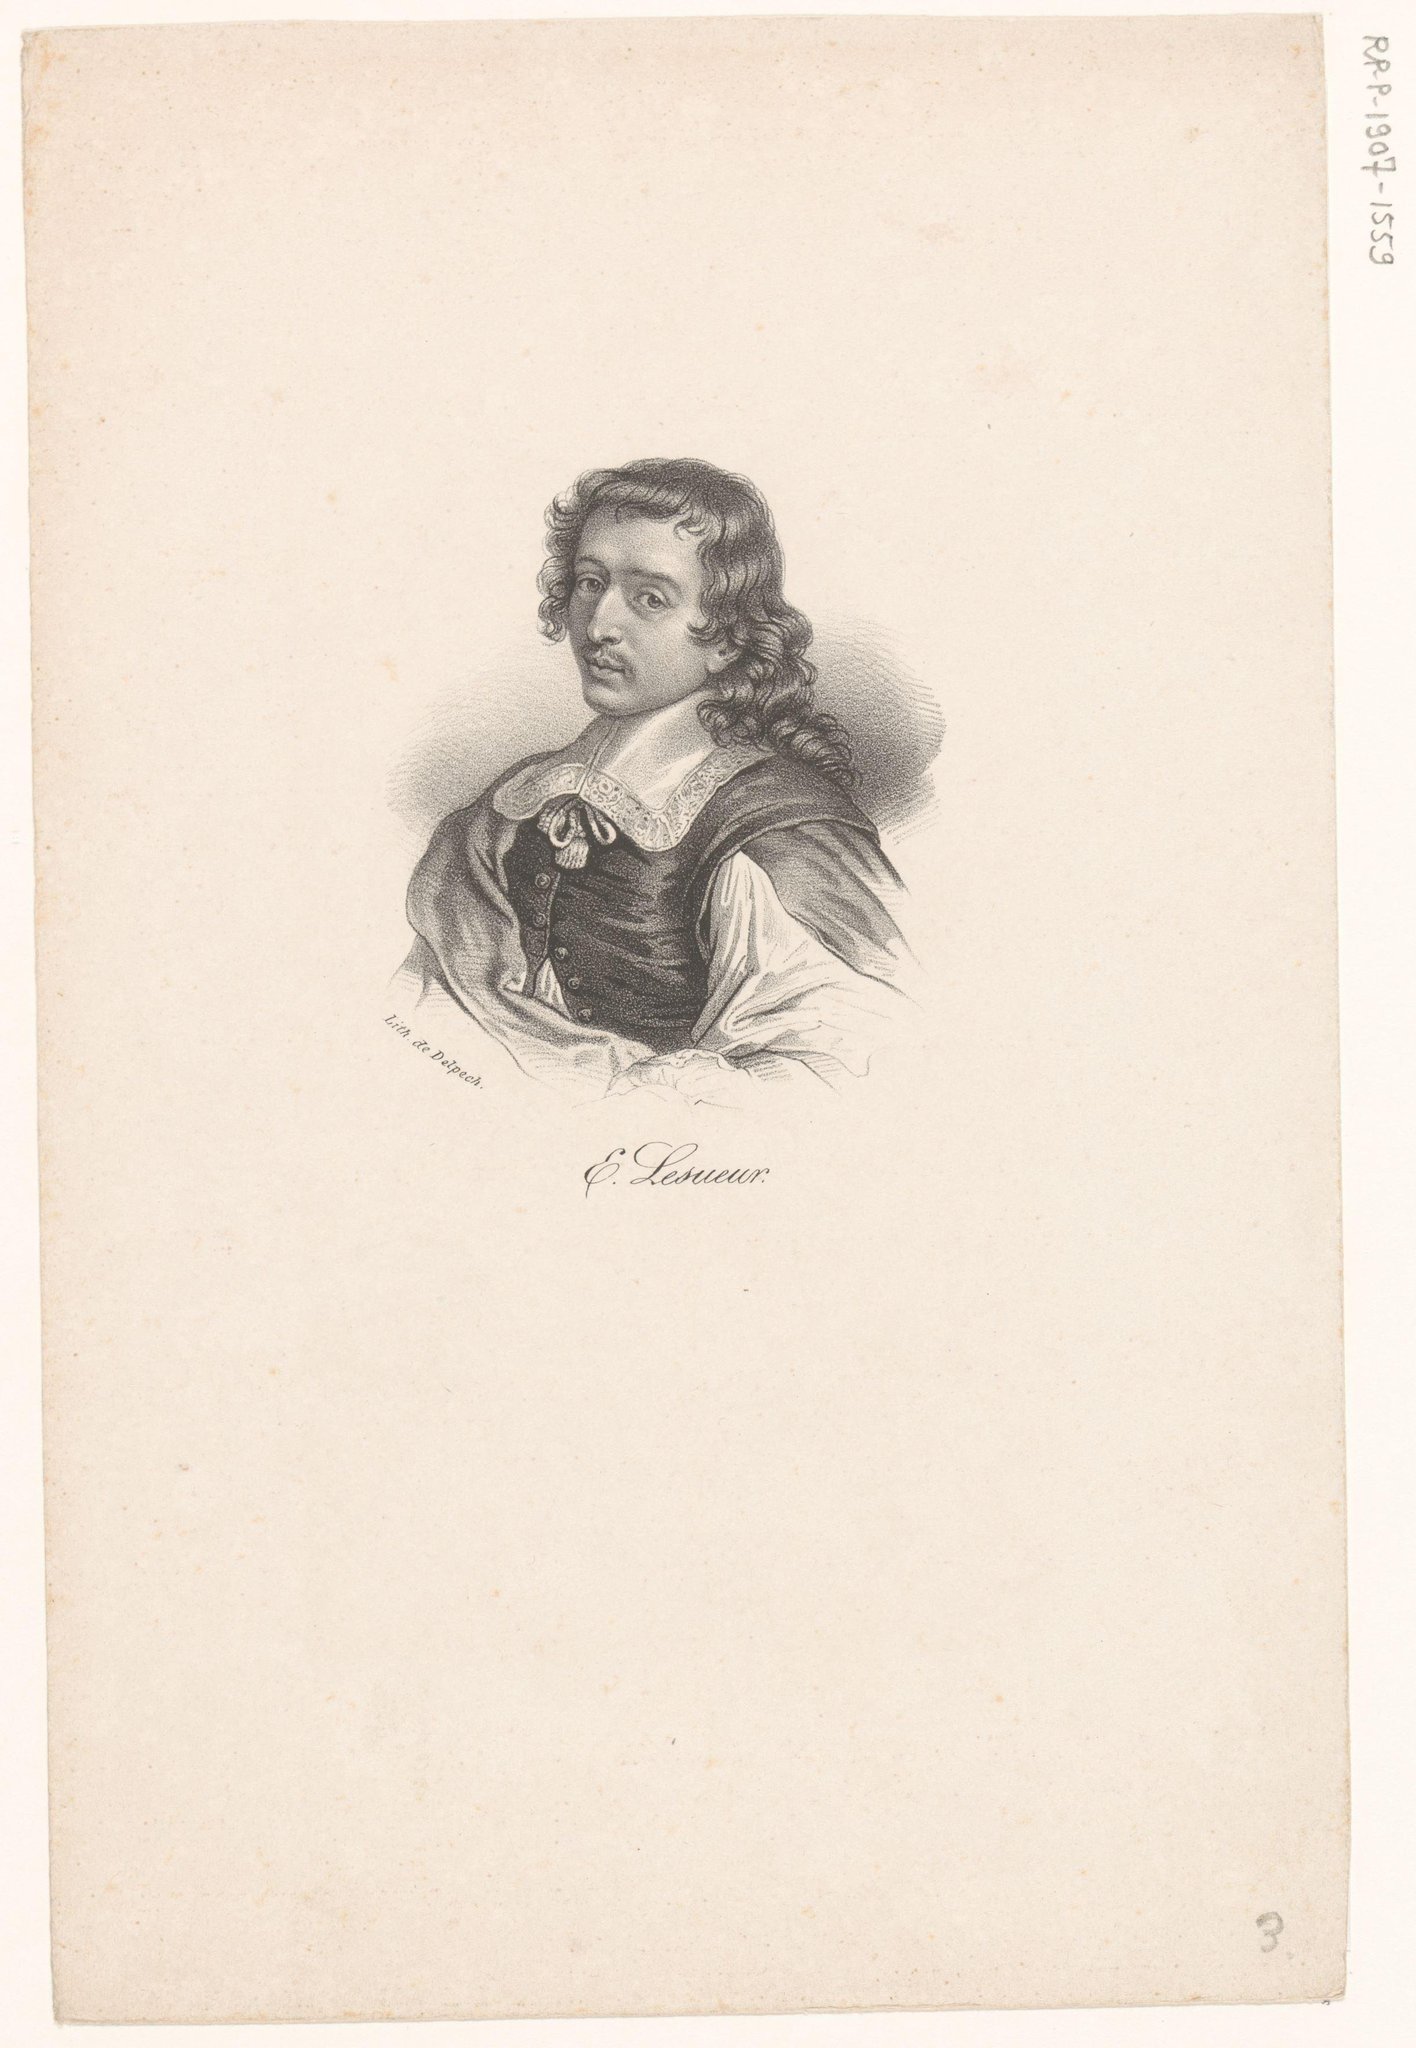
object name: print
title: Portret van Eustache Le Sueur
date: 1818-1842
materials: paper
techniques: lithograph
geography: paris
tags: paris, painter, draughtsman, eustache lesueur, historical persons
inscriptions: collector's mark: Lugt 2228a